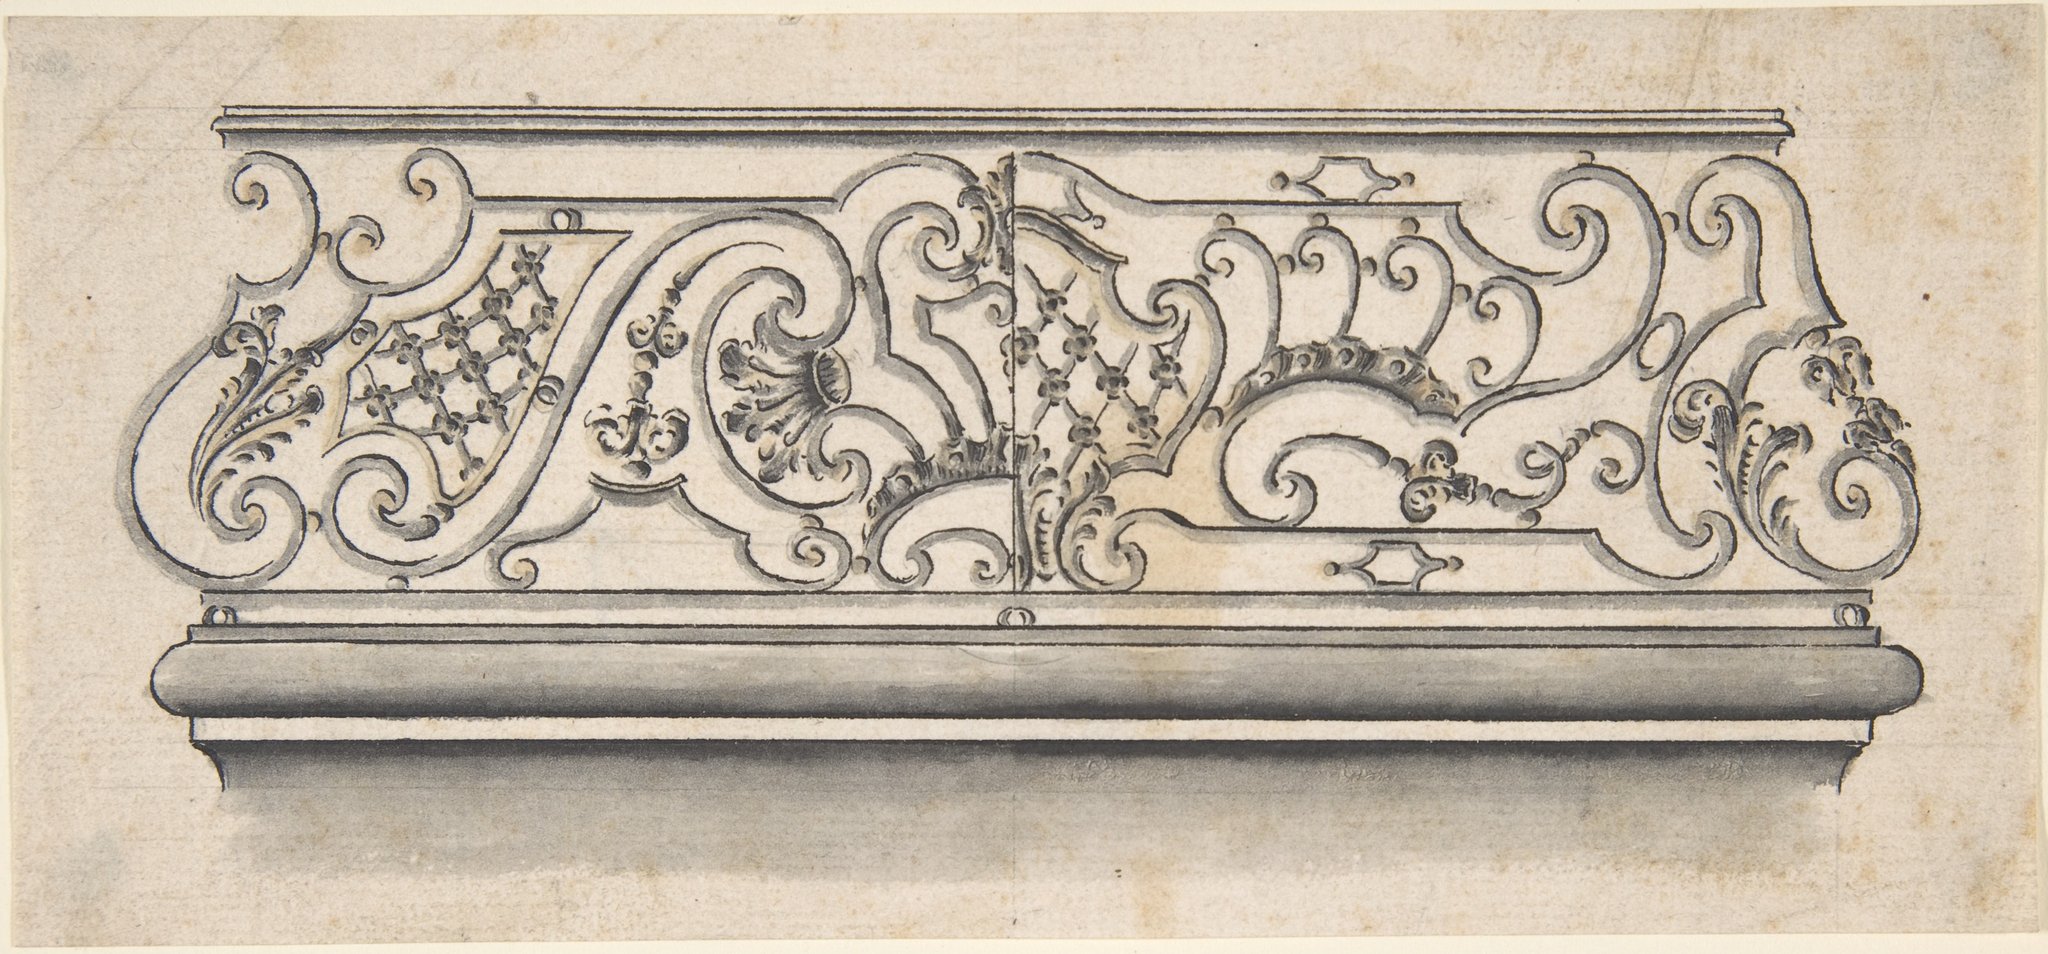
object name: drawing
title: Designs for iron work balcony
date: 1701-1800